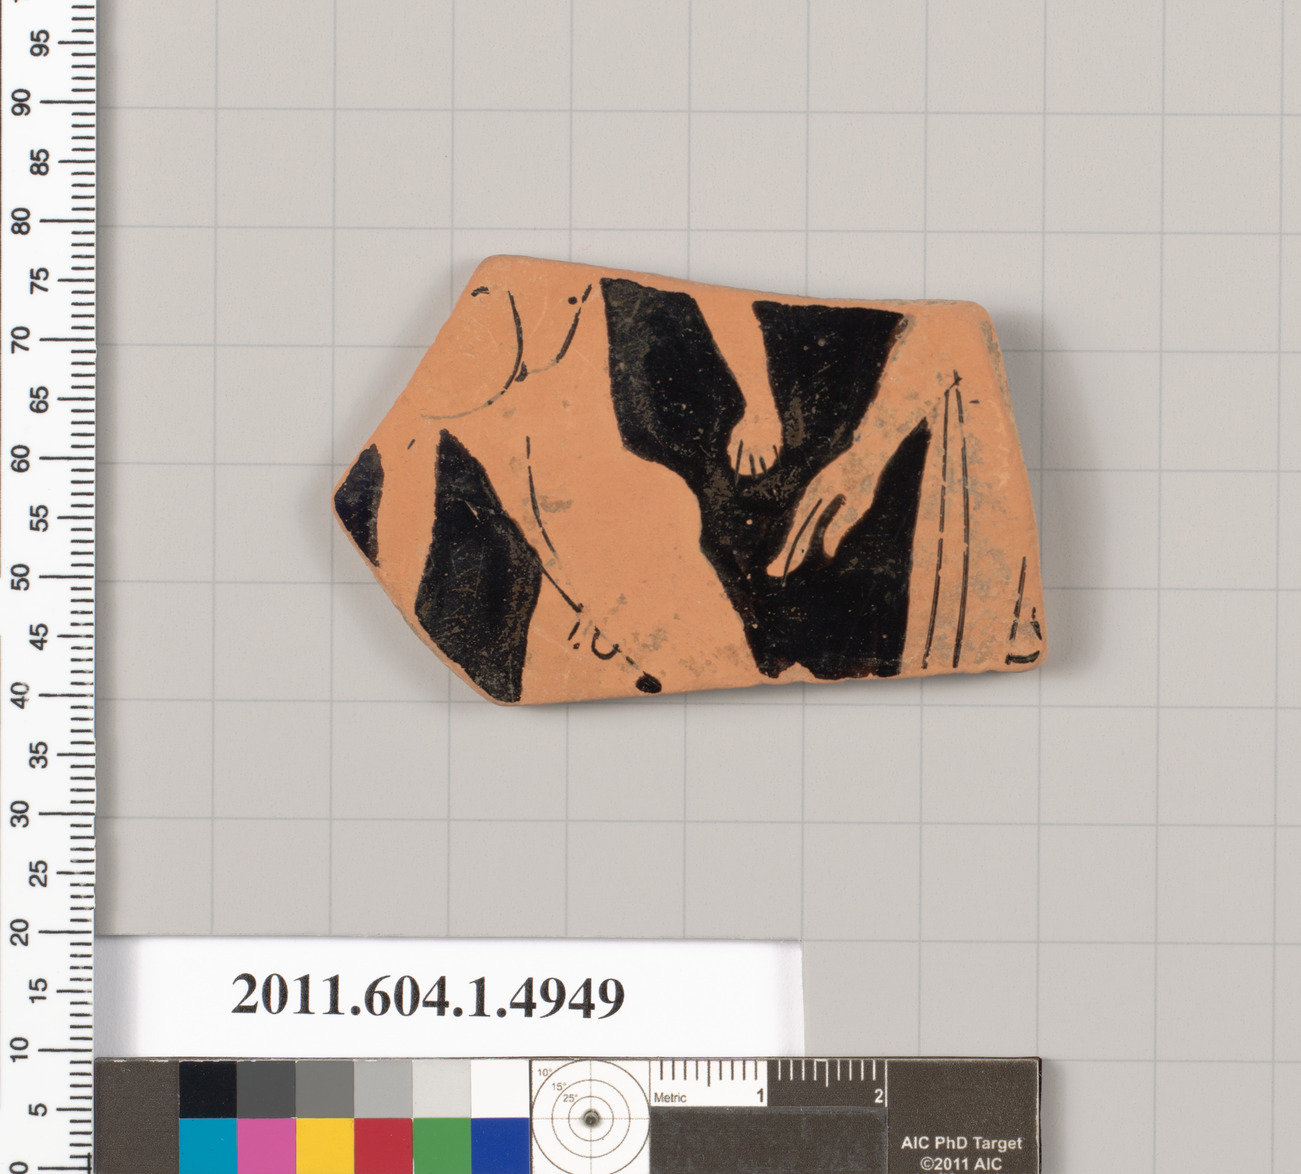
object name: kylix fragment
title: Terracotta fragment of a kylix (drinking cup)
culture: greek, attic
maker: epeleian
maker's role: artist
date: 520-500 BCE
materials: terracotta